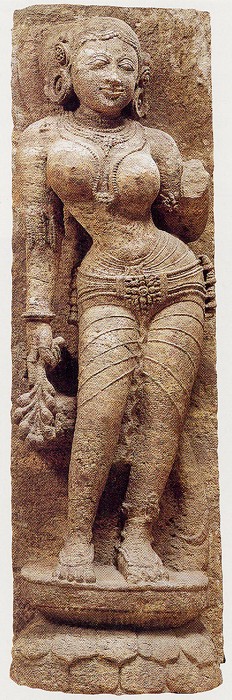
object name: figure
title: Tree Dryad (Shalabhanjika)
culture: indian, orissan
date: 1101-1300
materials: stone